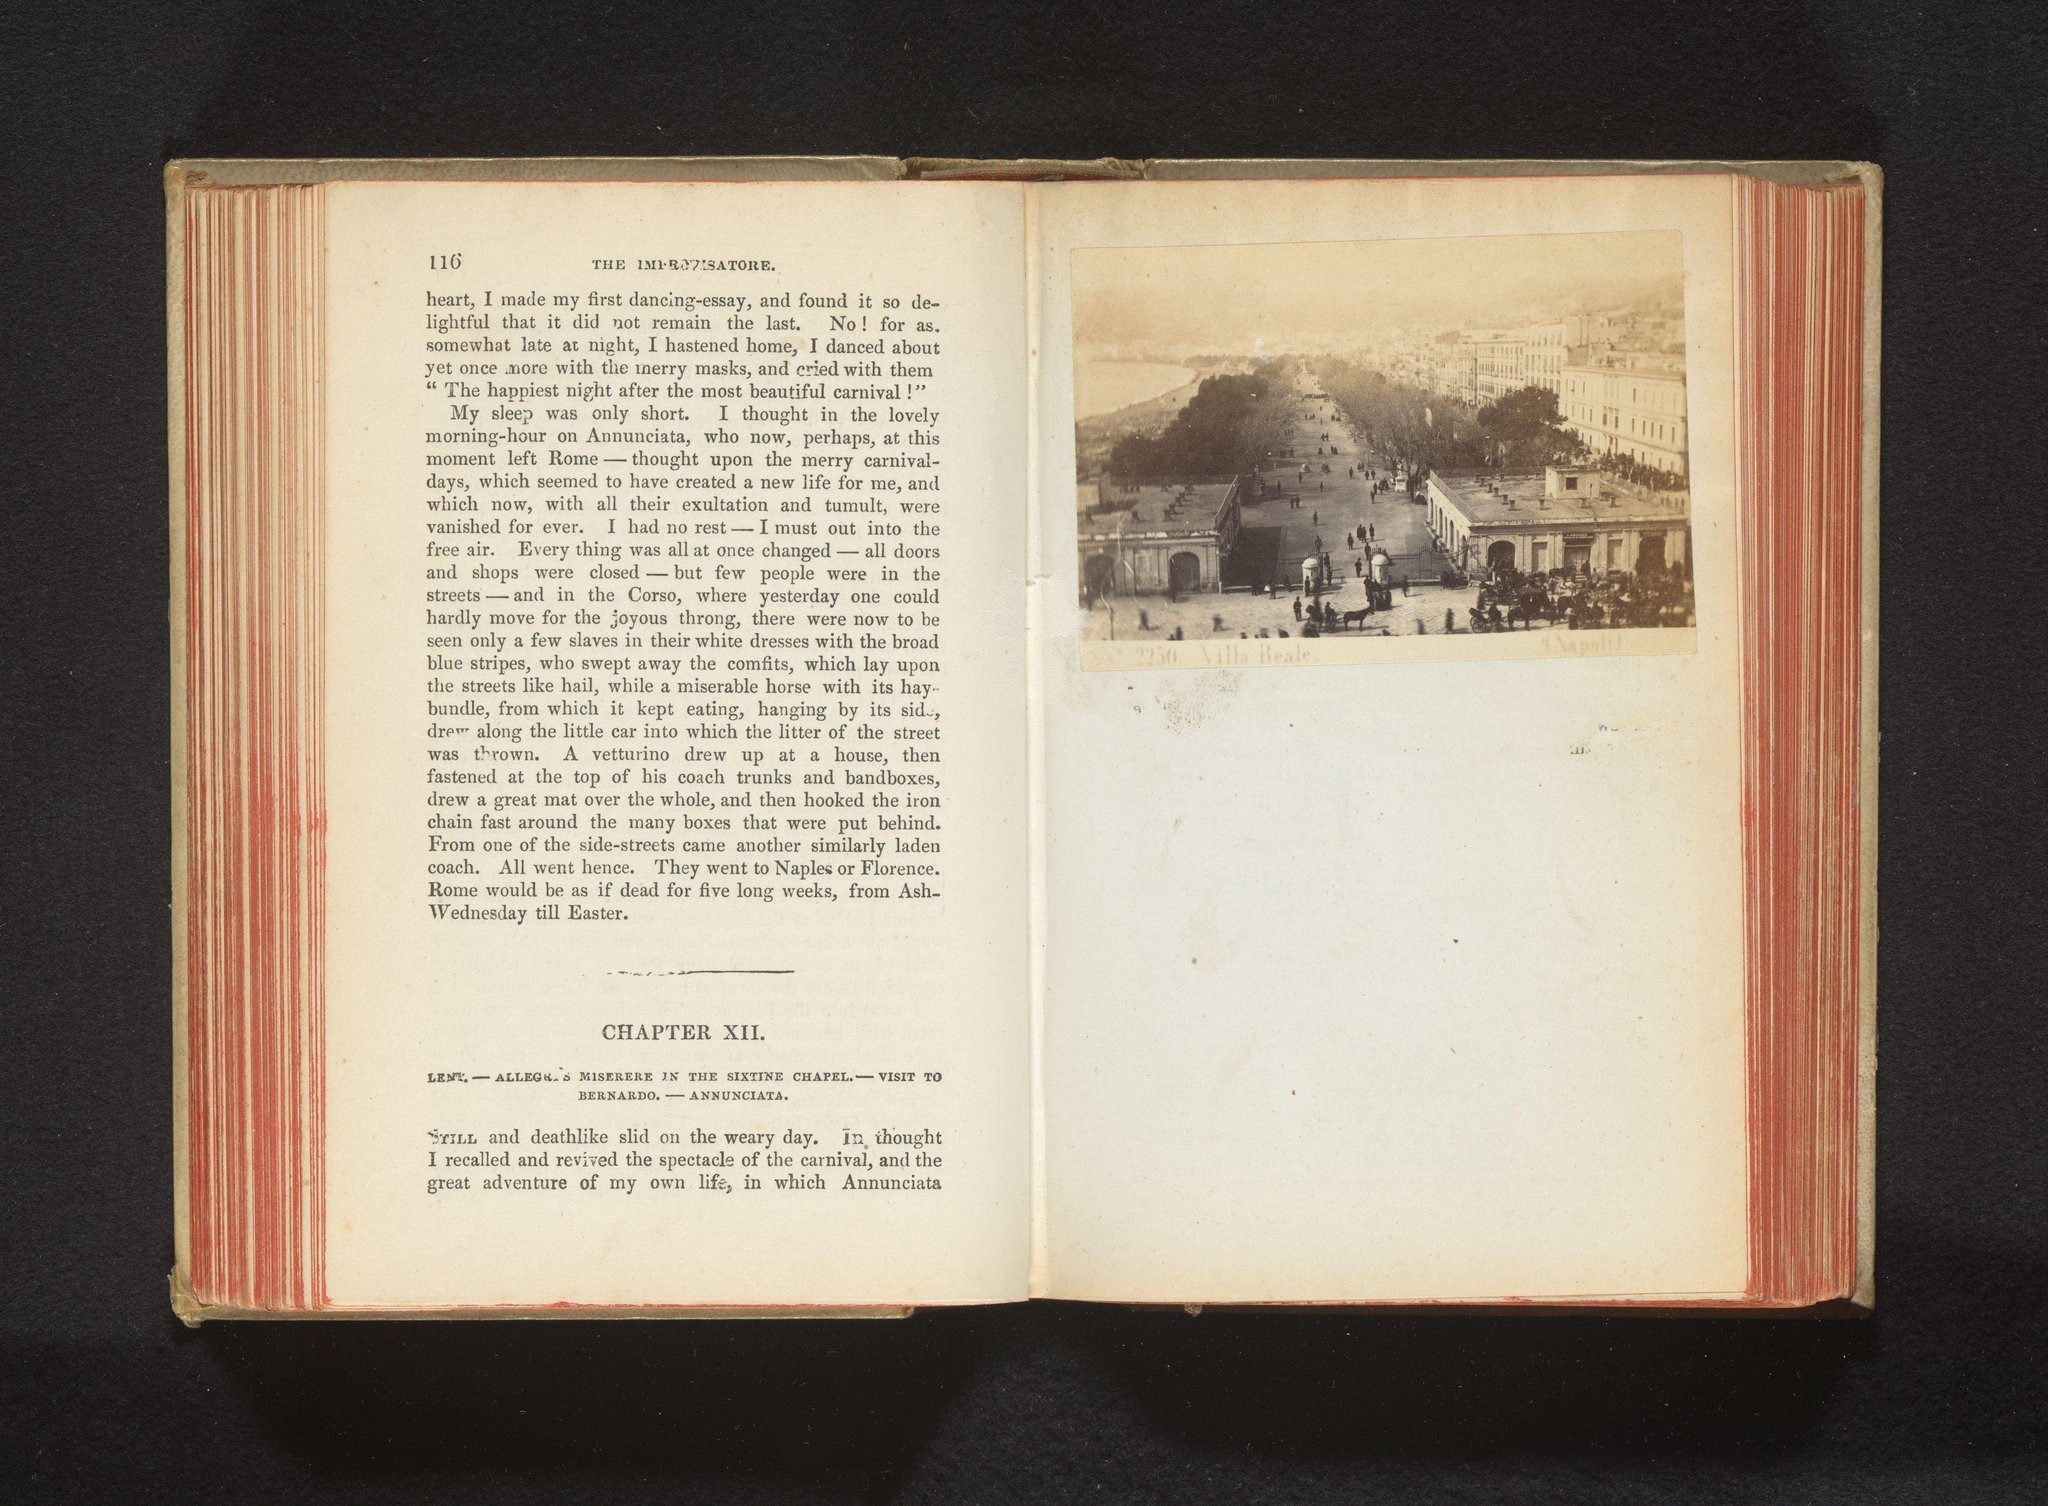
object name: page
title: Gezicht op de Villa Comunale te Napels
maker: Anonymous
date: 1863-1873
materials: photographic support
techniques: albumen print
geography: naples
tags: public gardens, park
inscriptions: number: ‘No 2250’